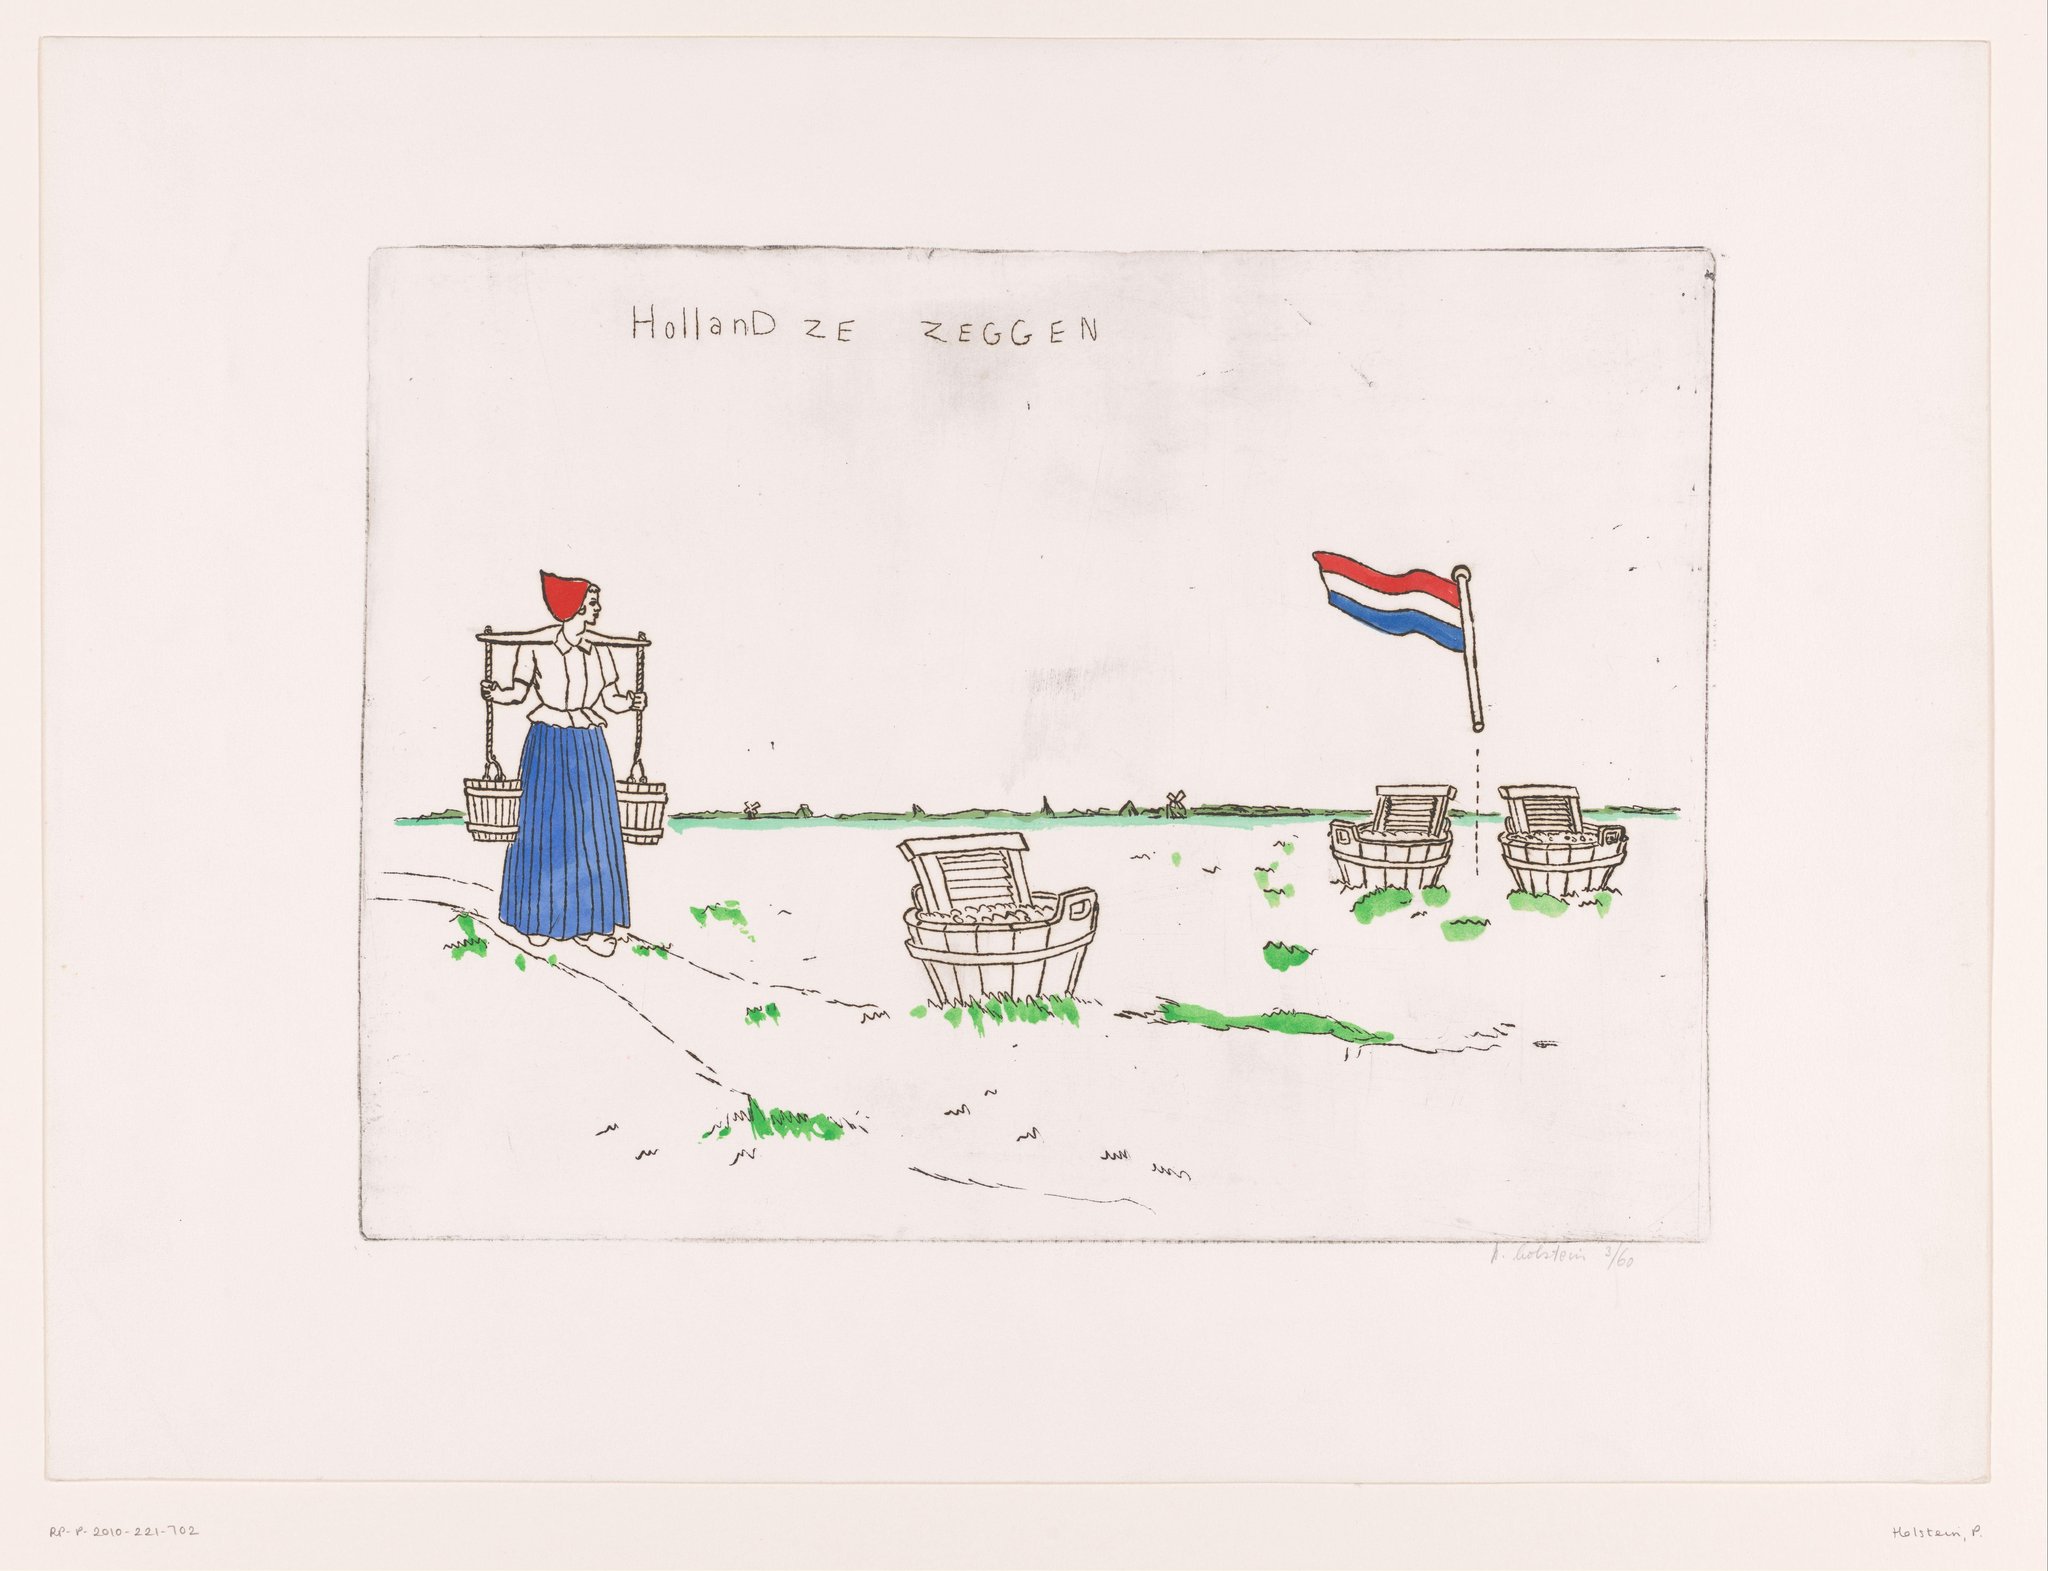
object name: print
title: Holland ze zeggen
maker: pieter holstein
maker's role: draughtsman, painter, print maker, sculptor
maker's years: 1934-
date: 1968-1969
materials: paper, watercolor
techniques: brush, etching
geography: amsterdam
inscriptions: title: ‘HollanD ZE ZEGGEN’, edition: ‘3/60’, signature: ‘p. holstein’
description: Links meisje met juk en twee emmers, op de voorgrond wastobbes, rechts een wapperende Nederlandse vlag.